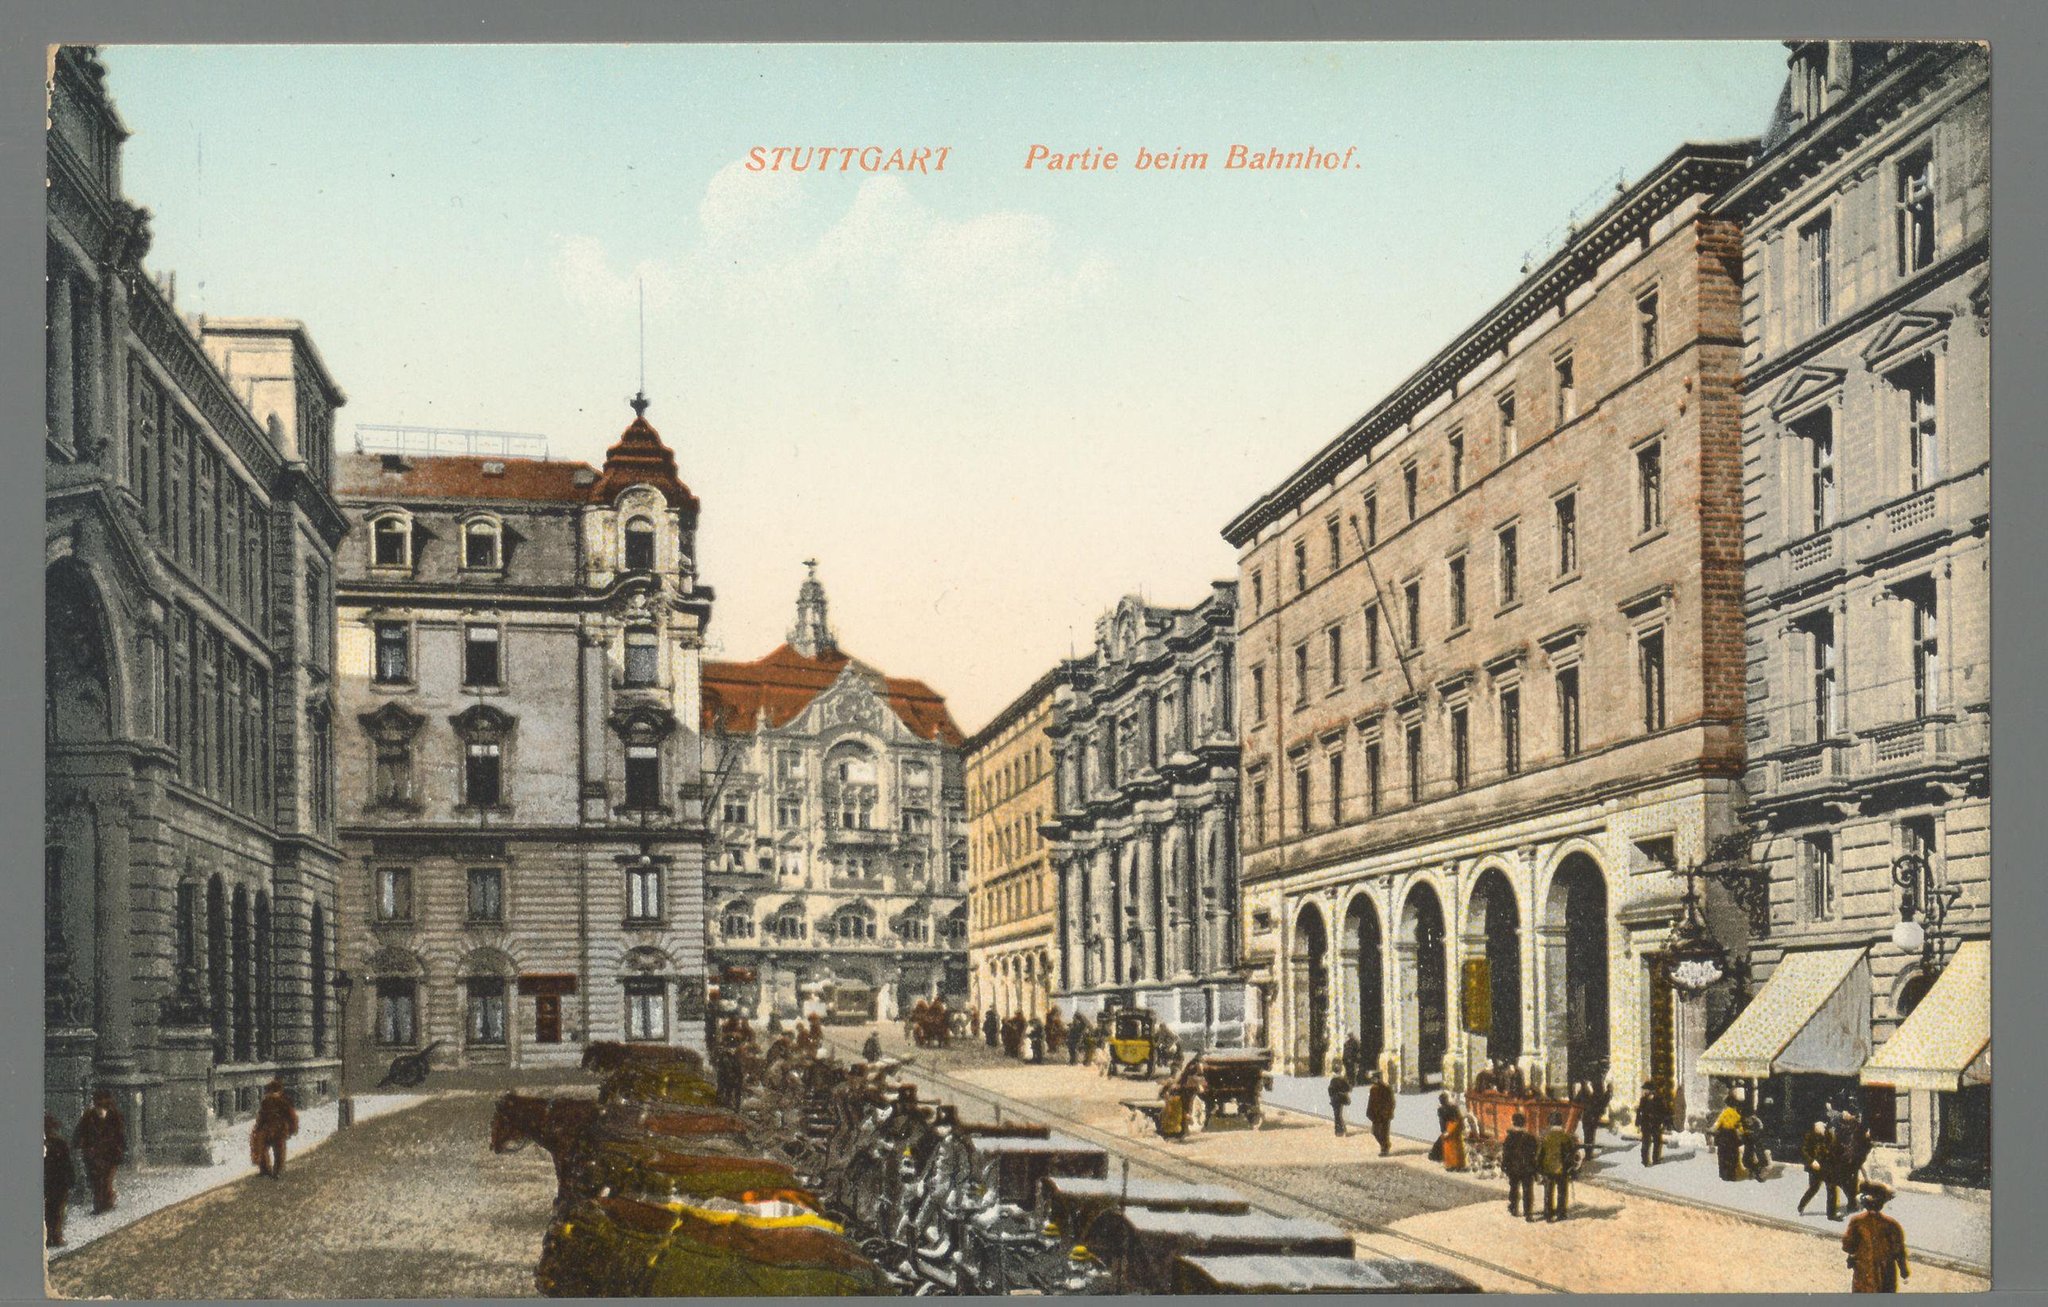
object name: ansichtkaart, prentbriefkaart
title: Stuttgart. Partie beim Bahnhof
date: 1905-1909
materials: cardboard, photographic process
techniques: writing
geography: stuttgart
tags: animal traction, animal-drawn vehicle (carriage etc.), station; shelter (railway, tramway)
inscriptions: monogram: ‘Photochrom M.S. P.’